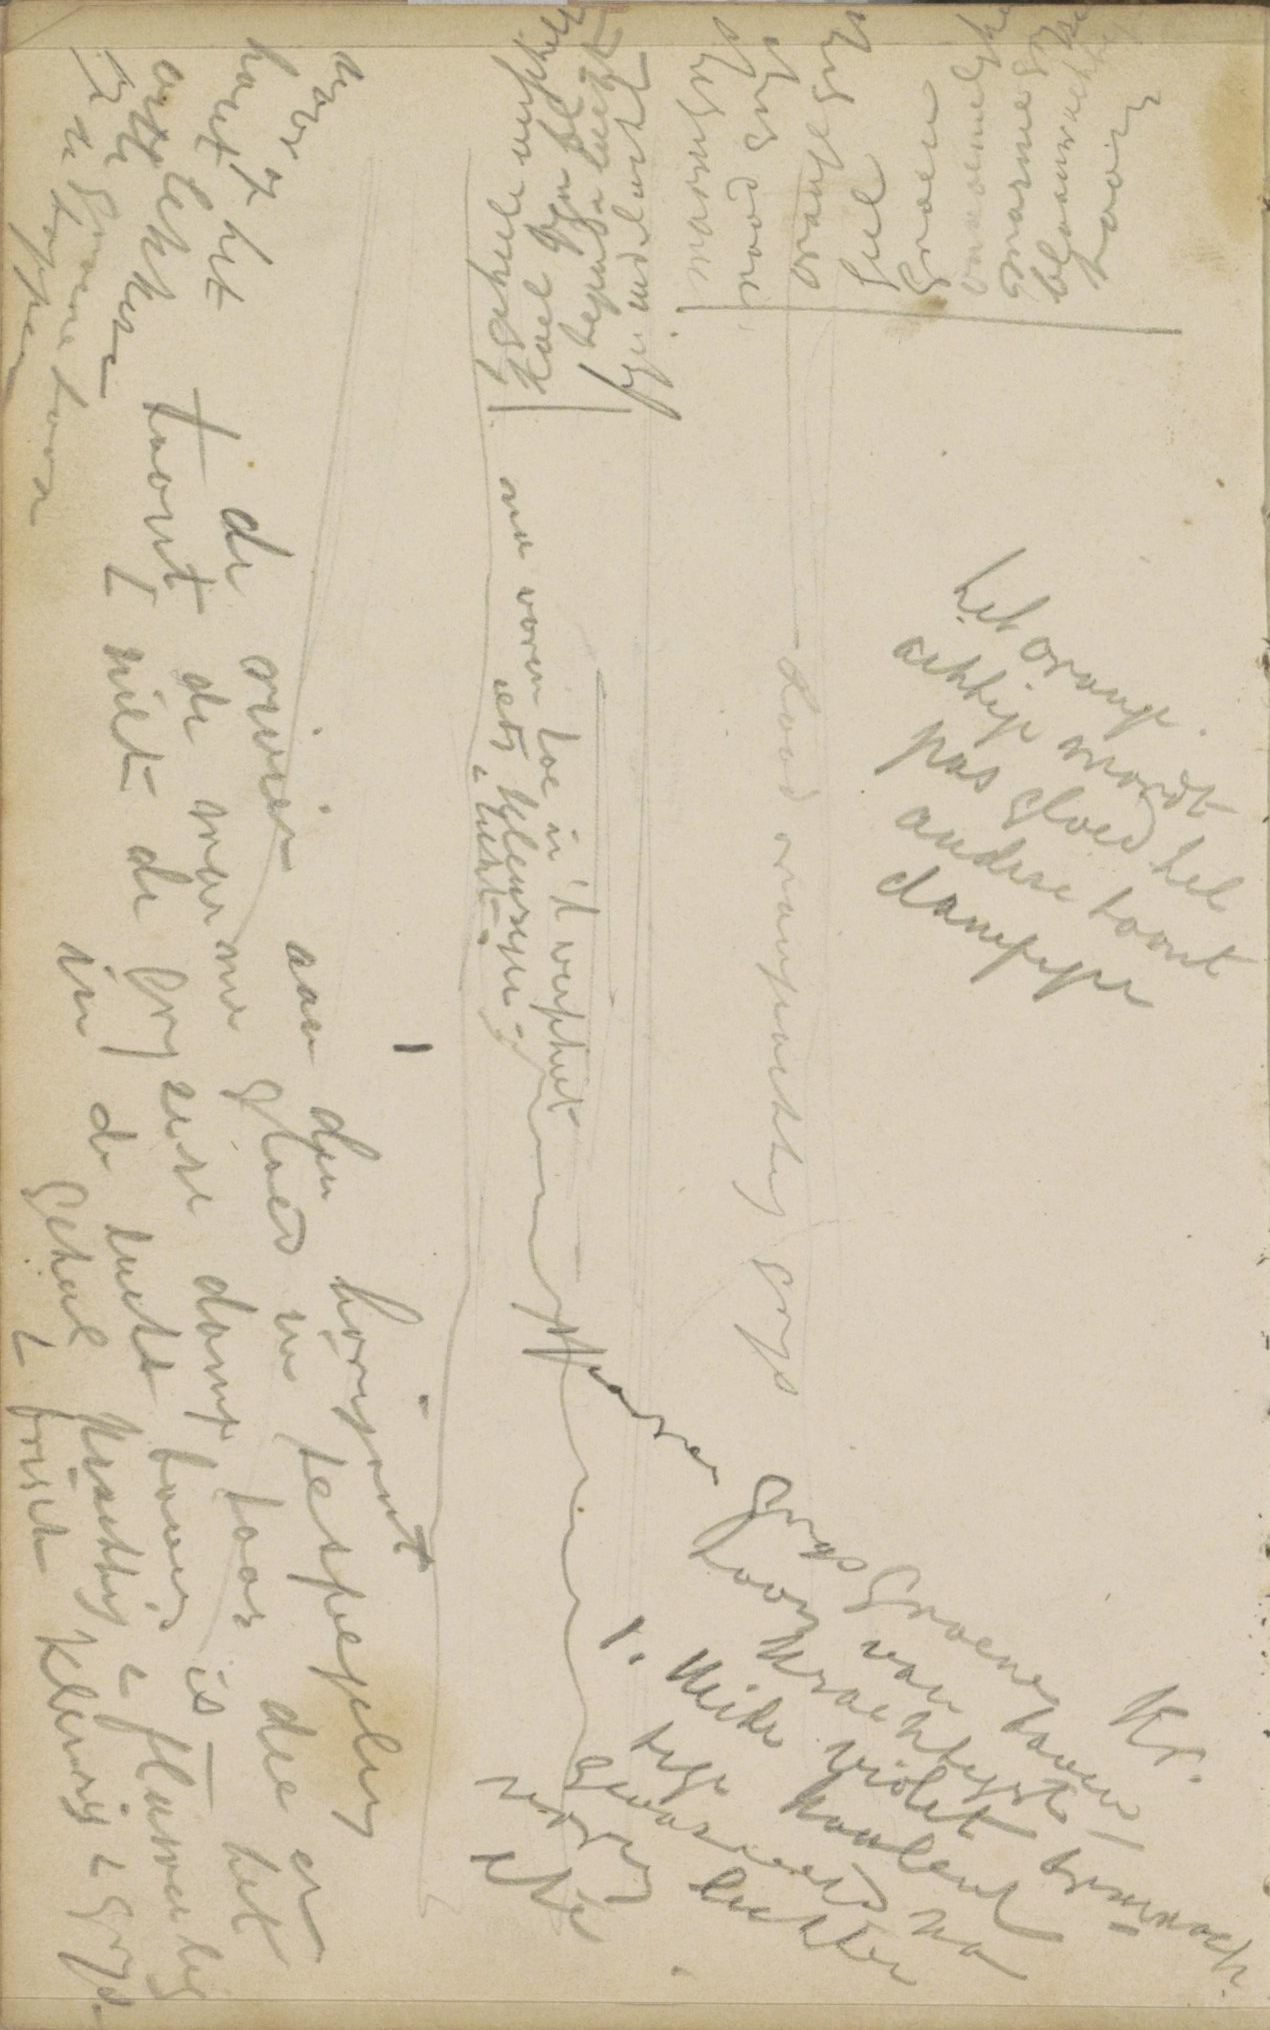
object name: sketchbook leaf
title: Landschap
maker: johannes tavenraat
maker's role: draughtsman, painter, print maker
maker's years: 1809-1881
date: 1839-1872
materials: paper, pencil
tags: landscapes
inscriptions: kleurnotitie, handgeschreven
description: Blad 66 verso uit een schetsboek met 73 bladen.